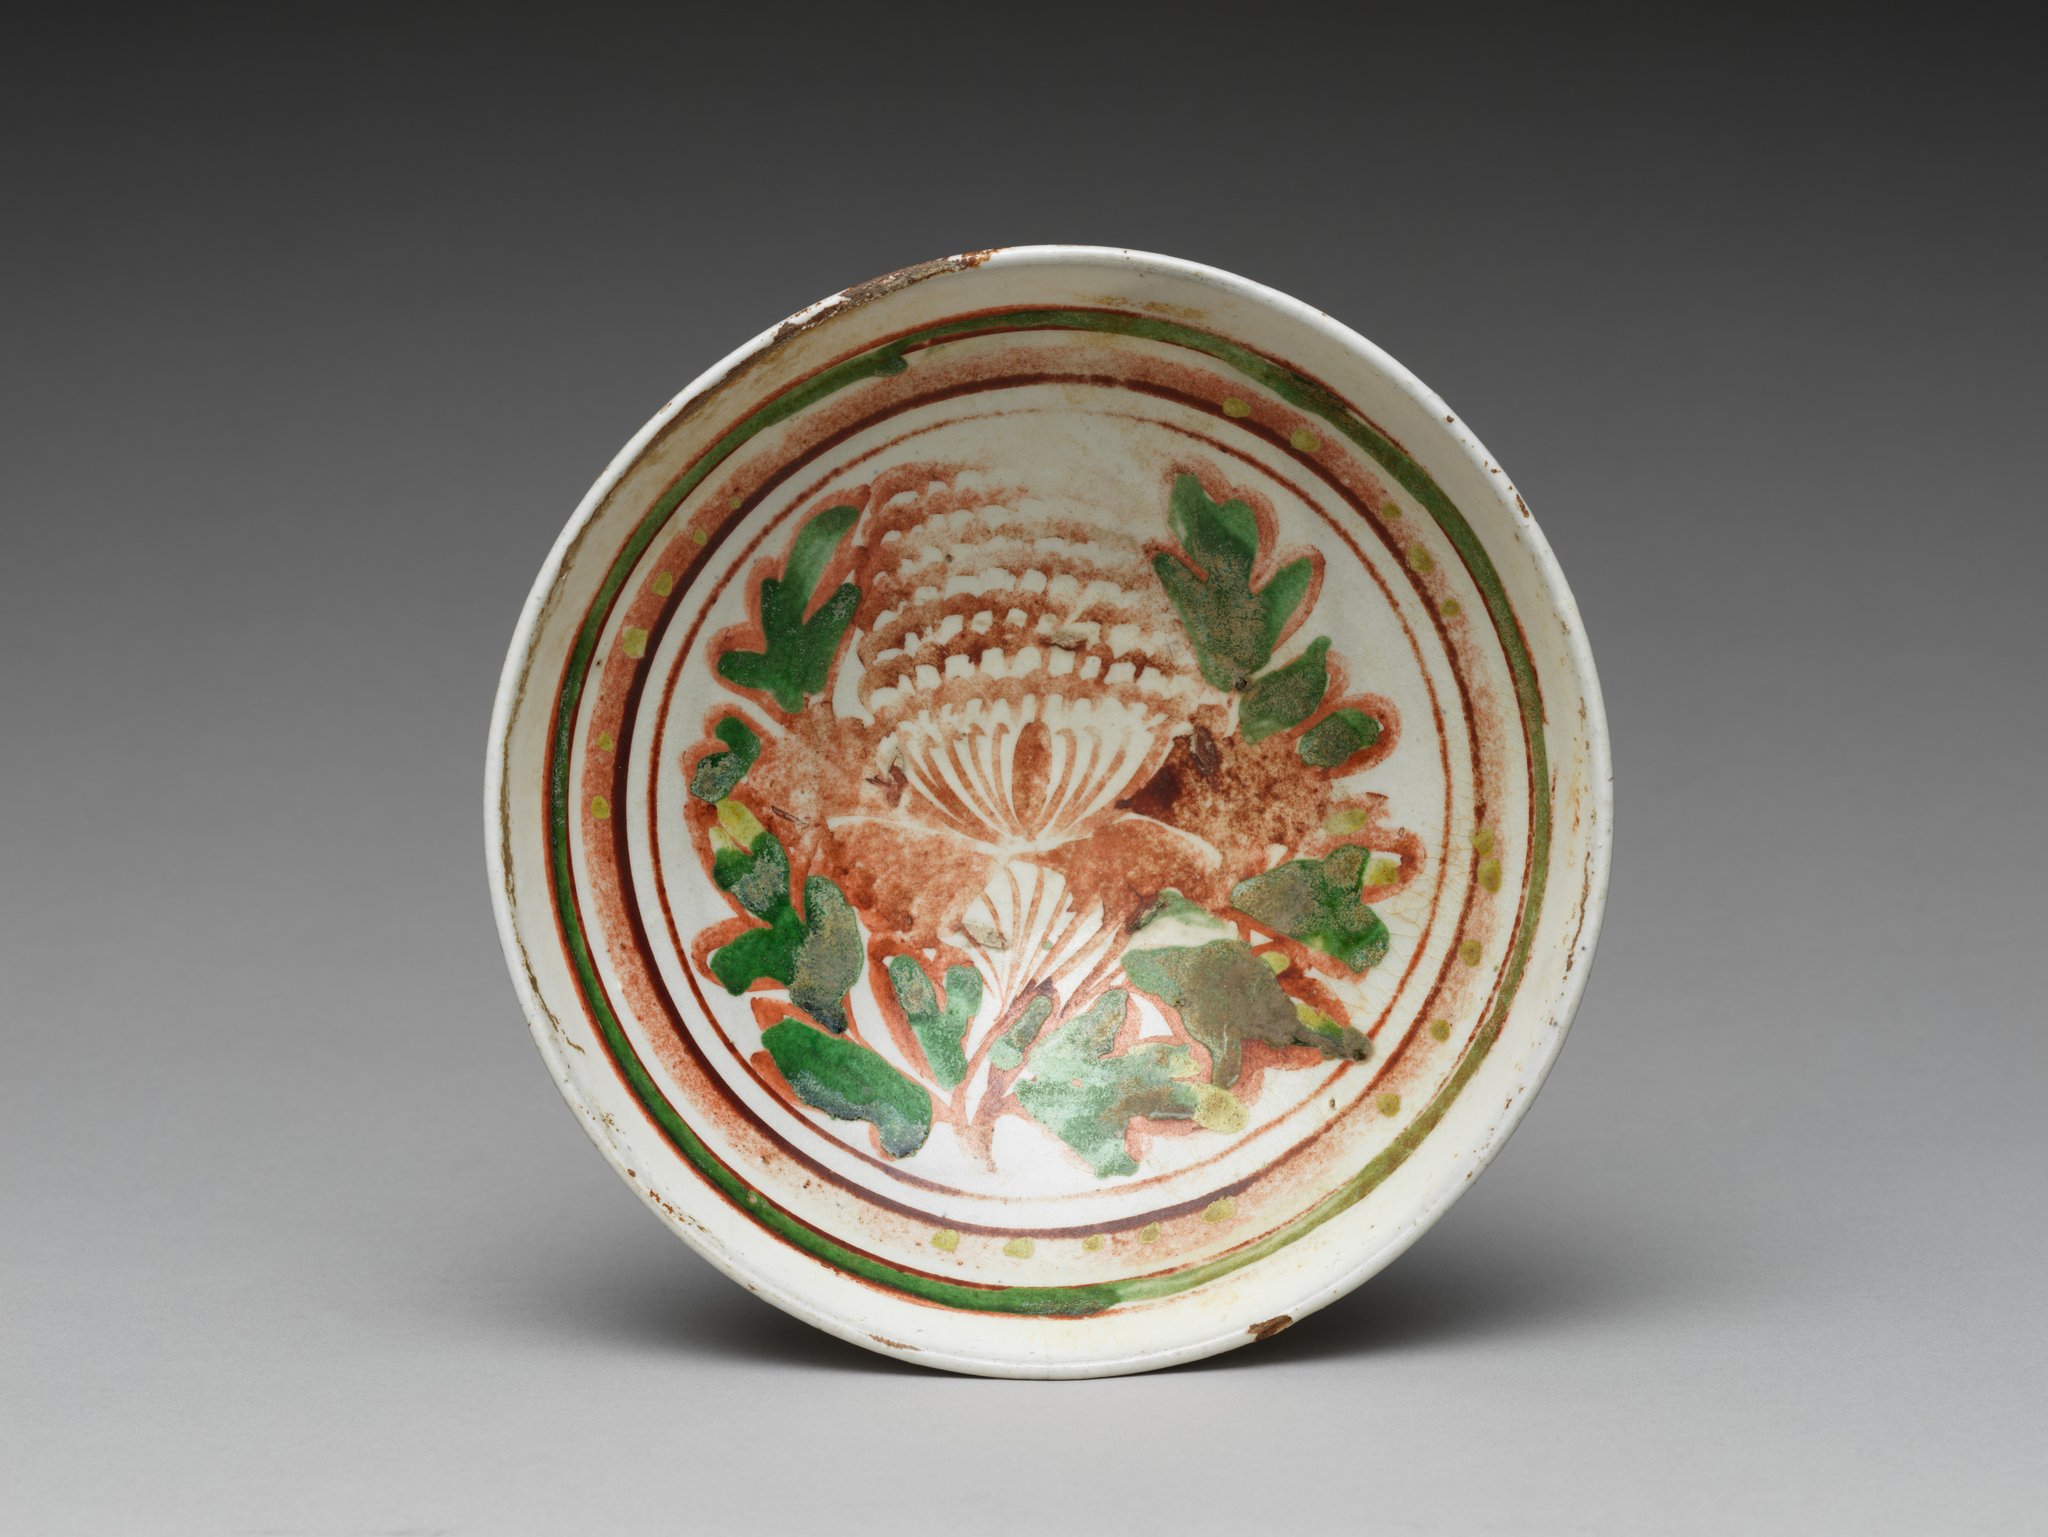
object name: bowl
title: Bowl with peony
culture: chinese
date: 1167-1233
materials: enamel, stoneware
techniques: overglaze, painting